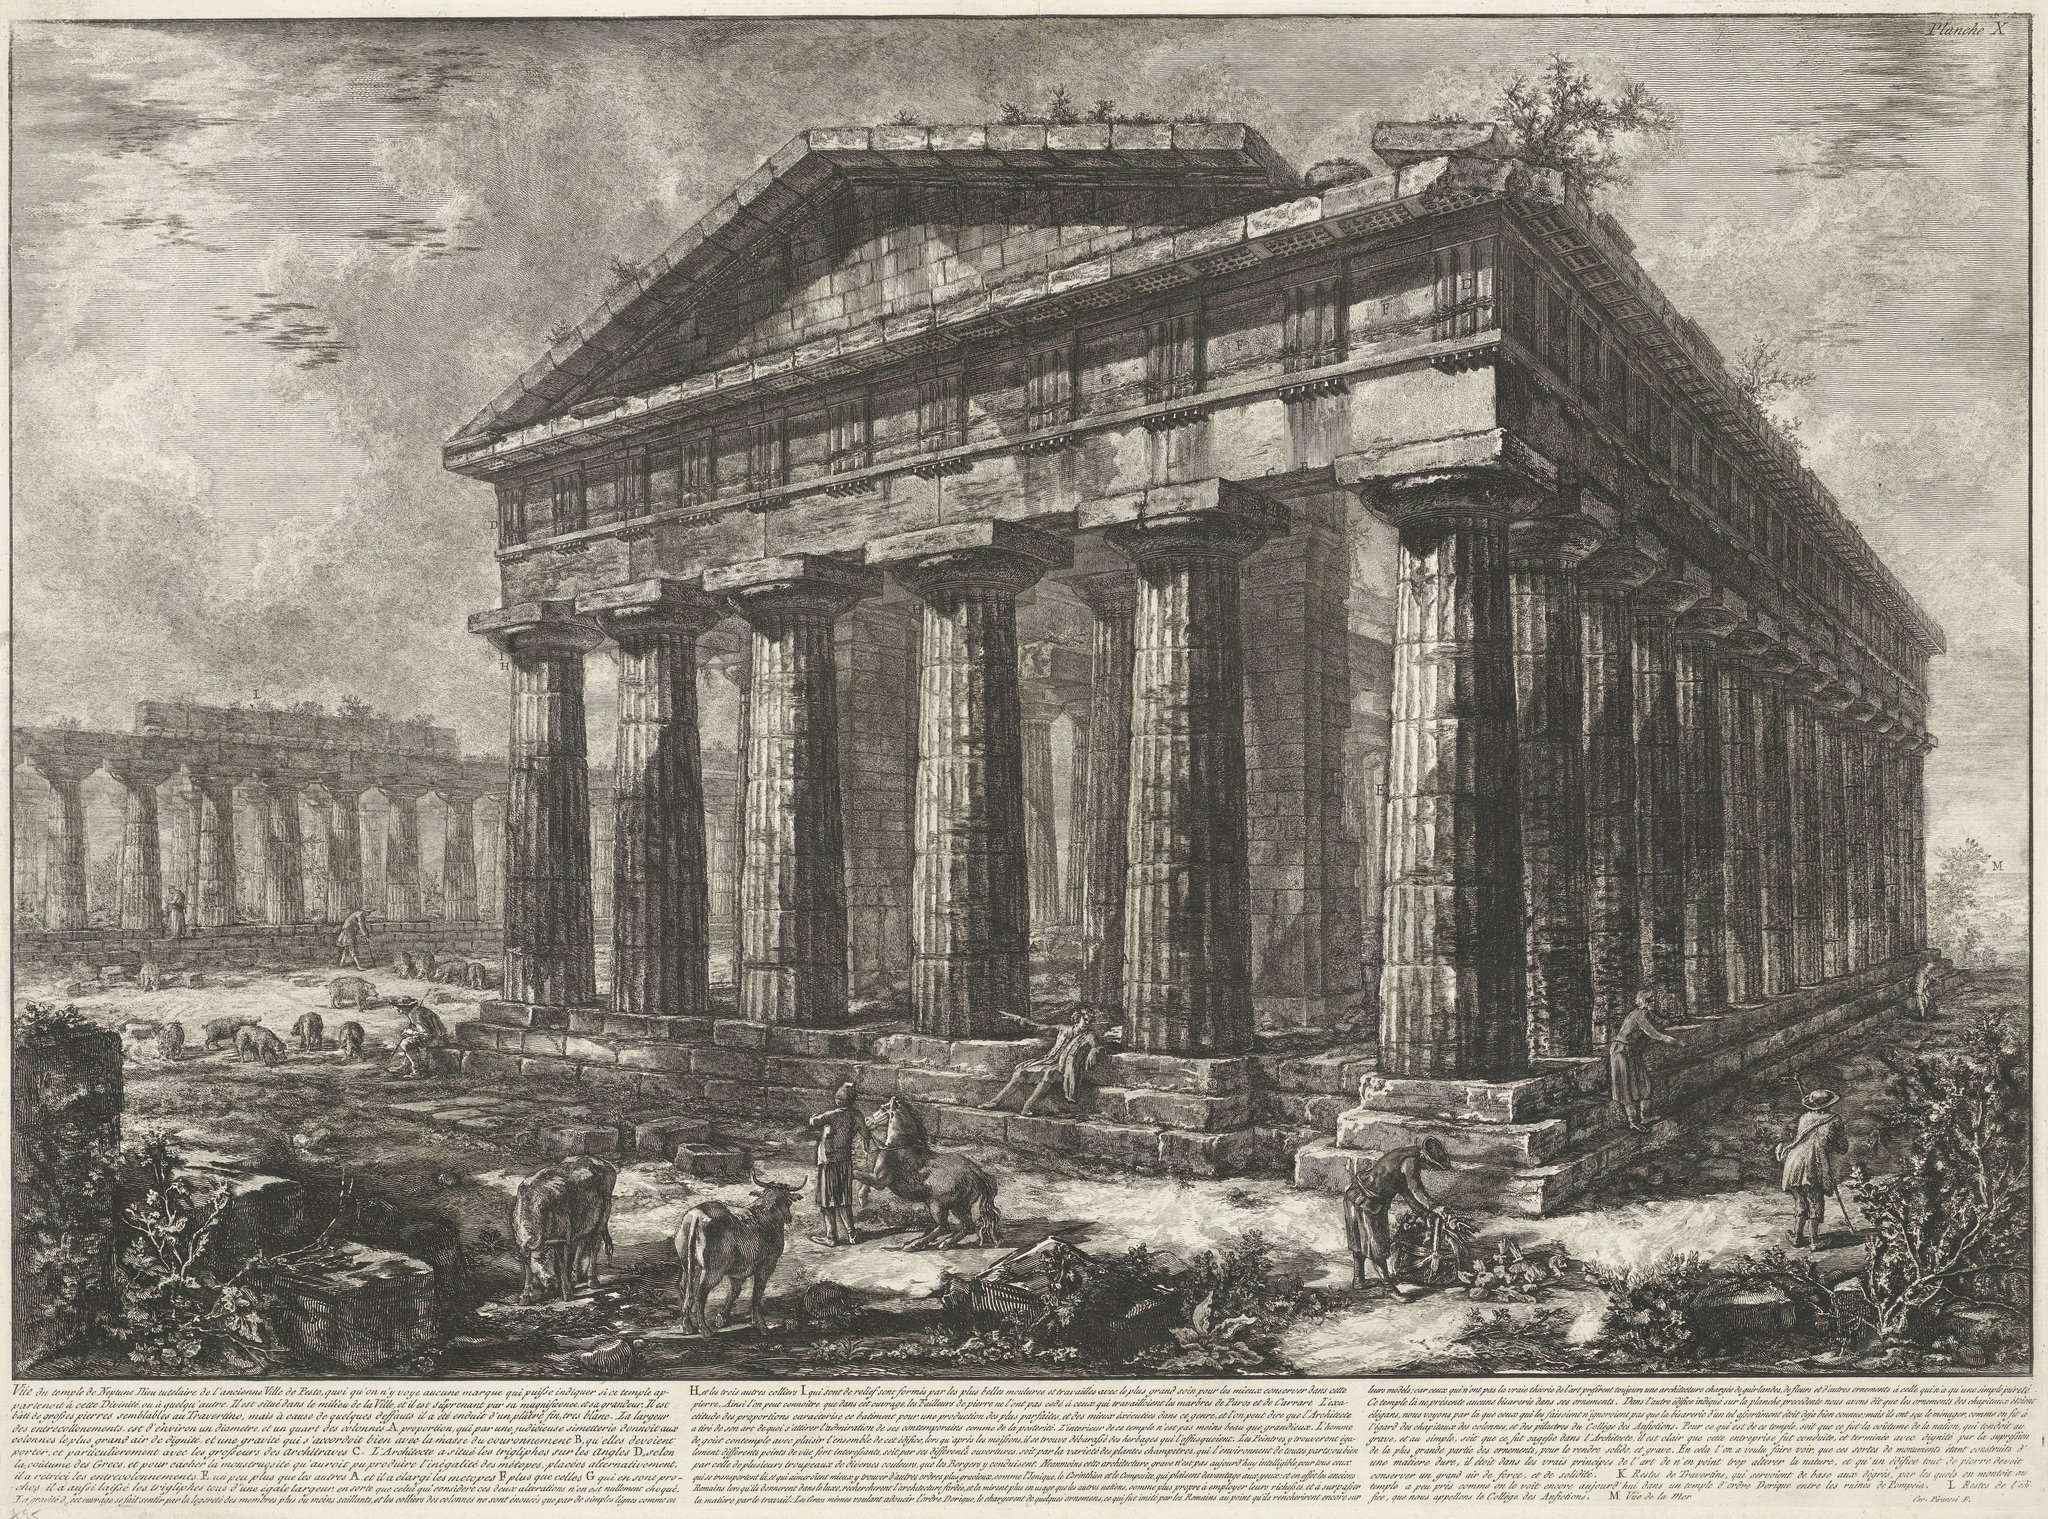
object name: print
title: Tempel van Neptunus te Paestum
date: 1778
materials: paper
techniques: etching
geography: rome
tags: (story of) neptune (poseidon), ruin of a building ~ architecture, landscape with ruins, temple, shrine ~ roman religion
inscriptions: collector's mark: Lugt 2760, collector's mark: Lugt 2228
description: Deze prent maakt deel uit van een reeks van 20 prenten (+ titelprent) met gezichten op tempels te Paestum. De gebouwen en de vegetatie op de prenten zijn uitgevoerd door Giovanni Battista Piranesi. De figuren zijn mogelijk uitgevoerd door zijn zoon Francesco.